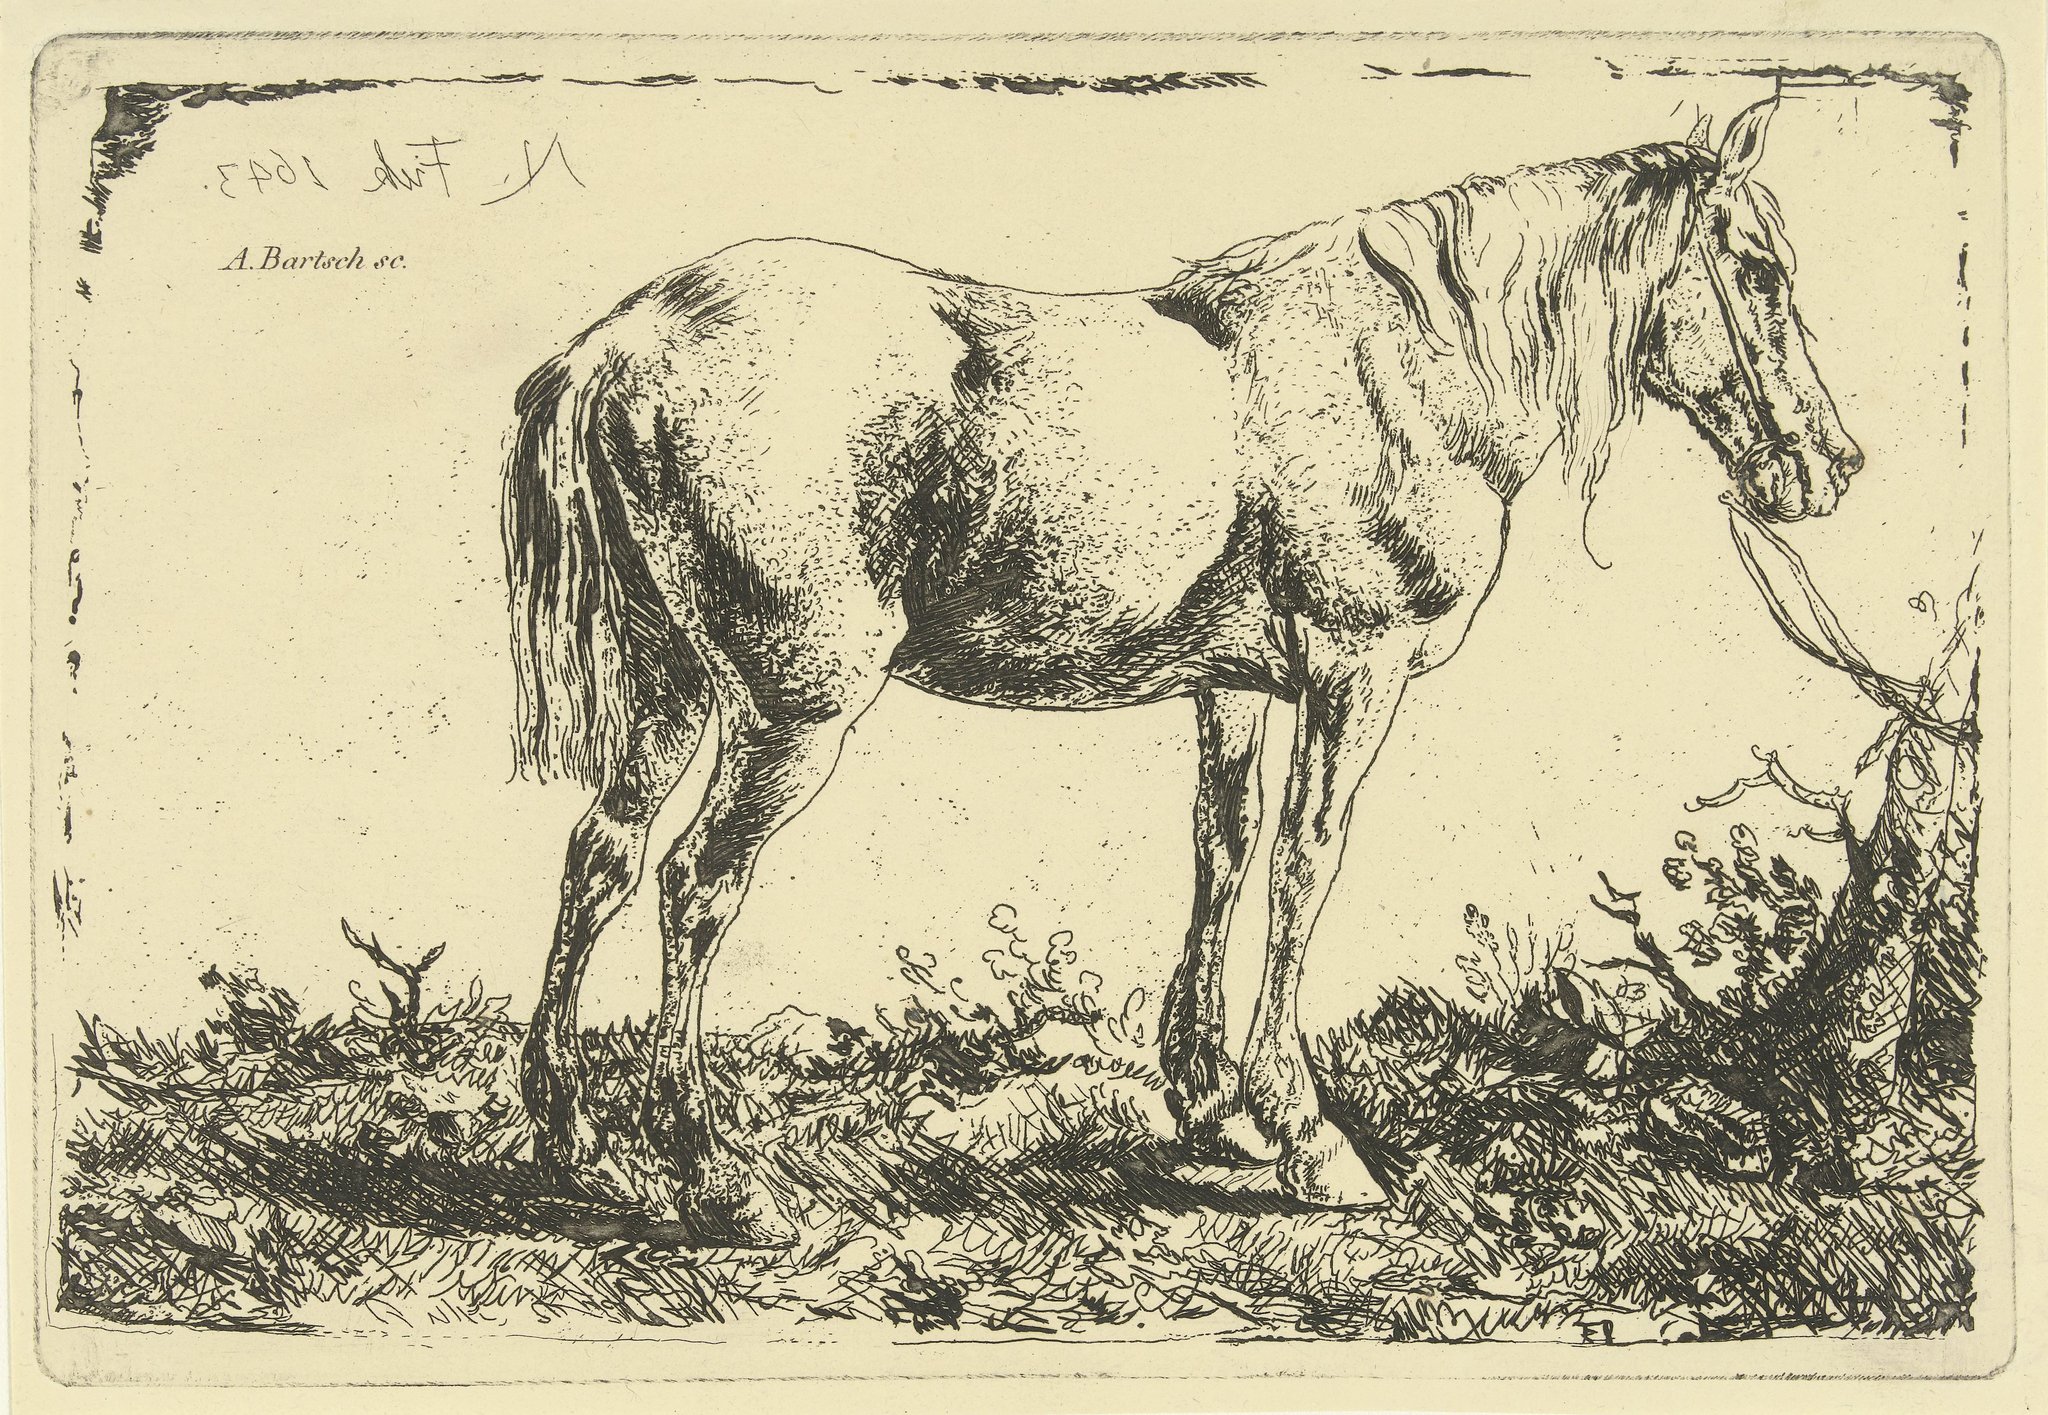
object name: print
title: Paard aan een boom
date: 1767-1821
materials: paper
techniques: etching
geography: haarlem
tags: horse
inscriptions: collector's mark: Lugt 12